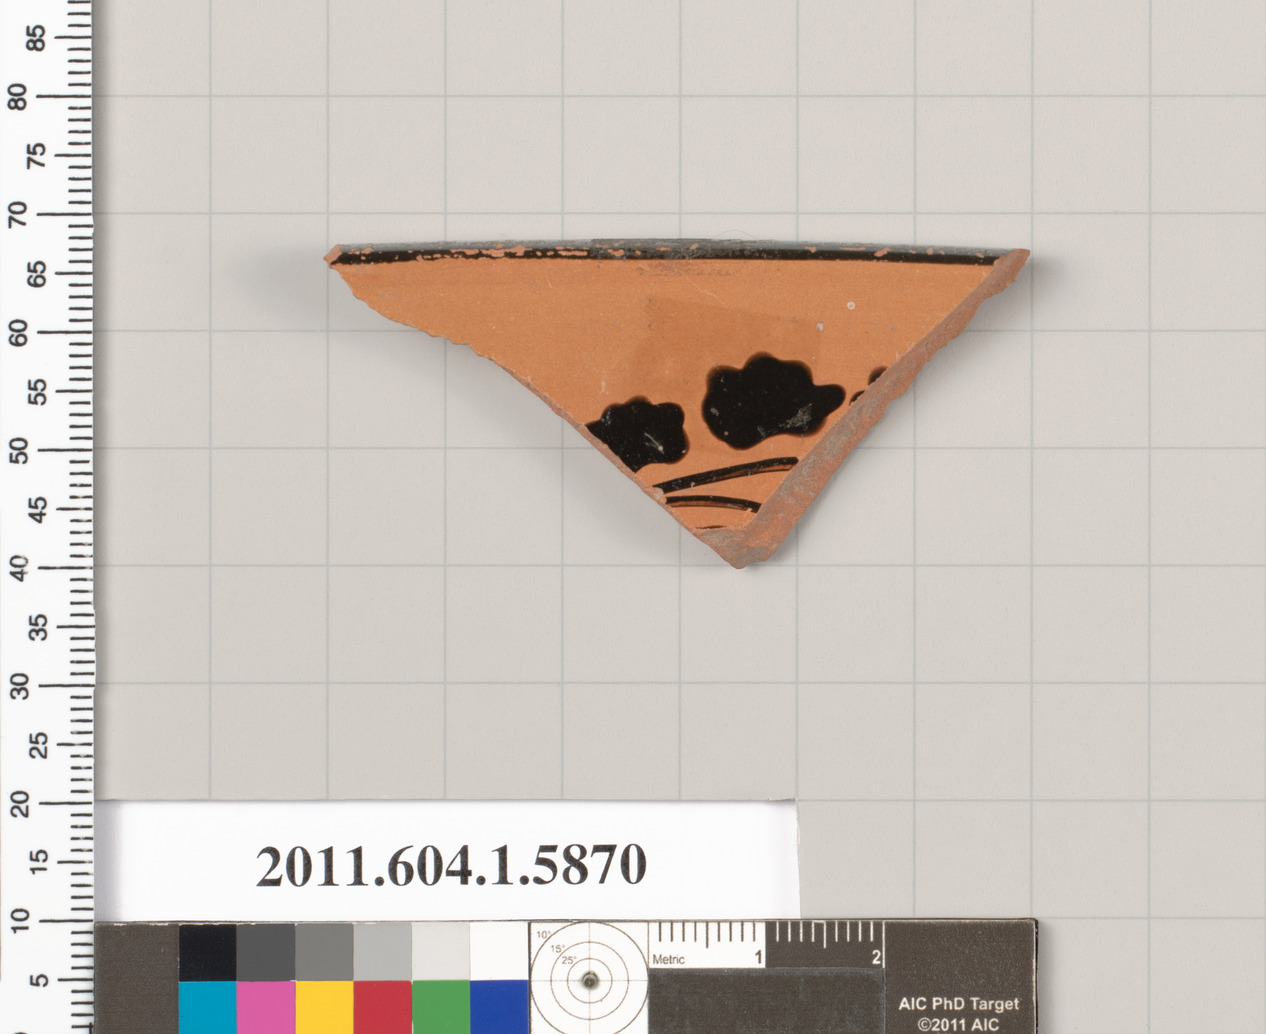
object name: kylix fragment, eye cup, bilingual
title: Terracotta fragment of a kylix (drinking cup)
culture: greek, attic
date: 433-567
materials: terracotta